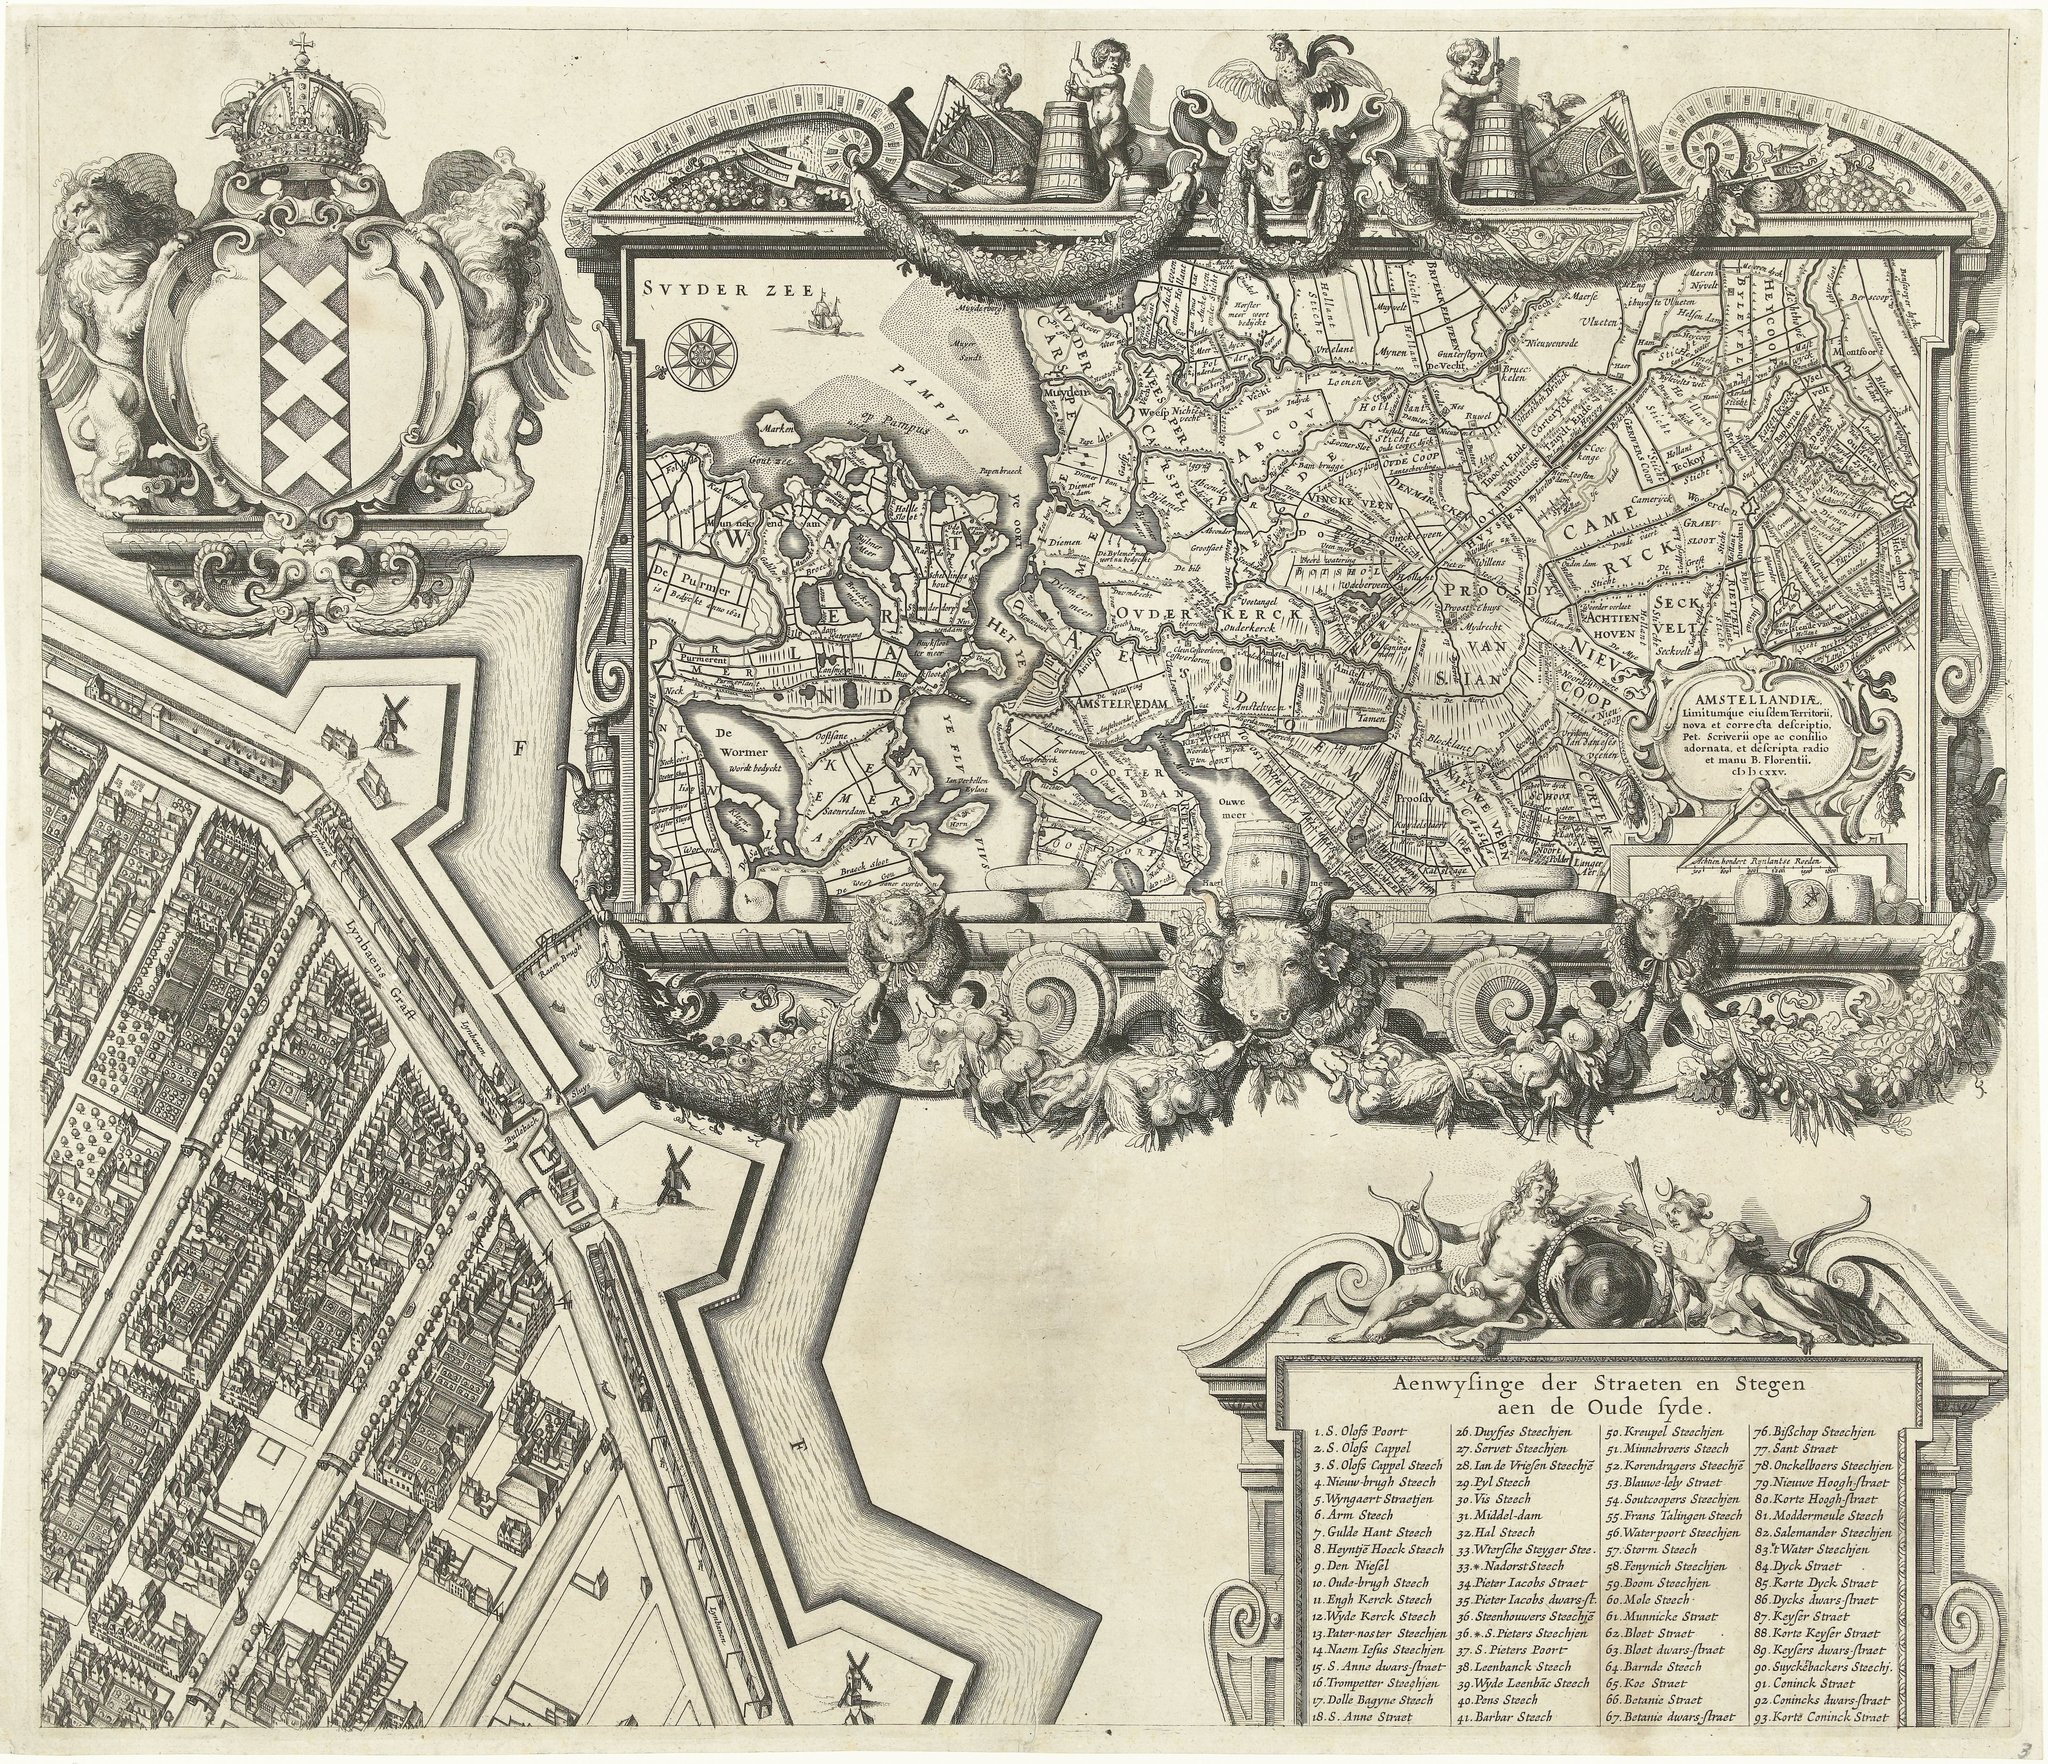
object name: print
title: Plattegrond van Amsterdam (blad rechtsboven)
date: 1625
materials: paper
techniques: etching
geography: amsterdam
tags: coat of arms (as symbol of the state, etc.), maps of separate countries or regions, compasses, maps of cities, amsterdam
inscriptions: collector's mark: Lugt 2228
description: Grote plattegrond van de stad Amsterdam uit 1625. Linksboven een gezicht op de stad en rechtsboven een kaart van de omgeving. Rechts een lijst met de namen van straten aan de Oude en de Nieuwe stadszijde. De plattegrond is samengesteld uit negen platen, waarvan twee ontbreken. Dit is het blad rechtsboven met de kaart van de omgeving van Amsterdam: Amstelland.